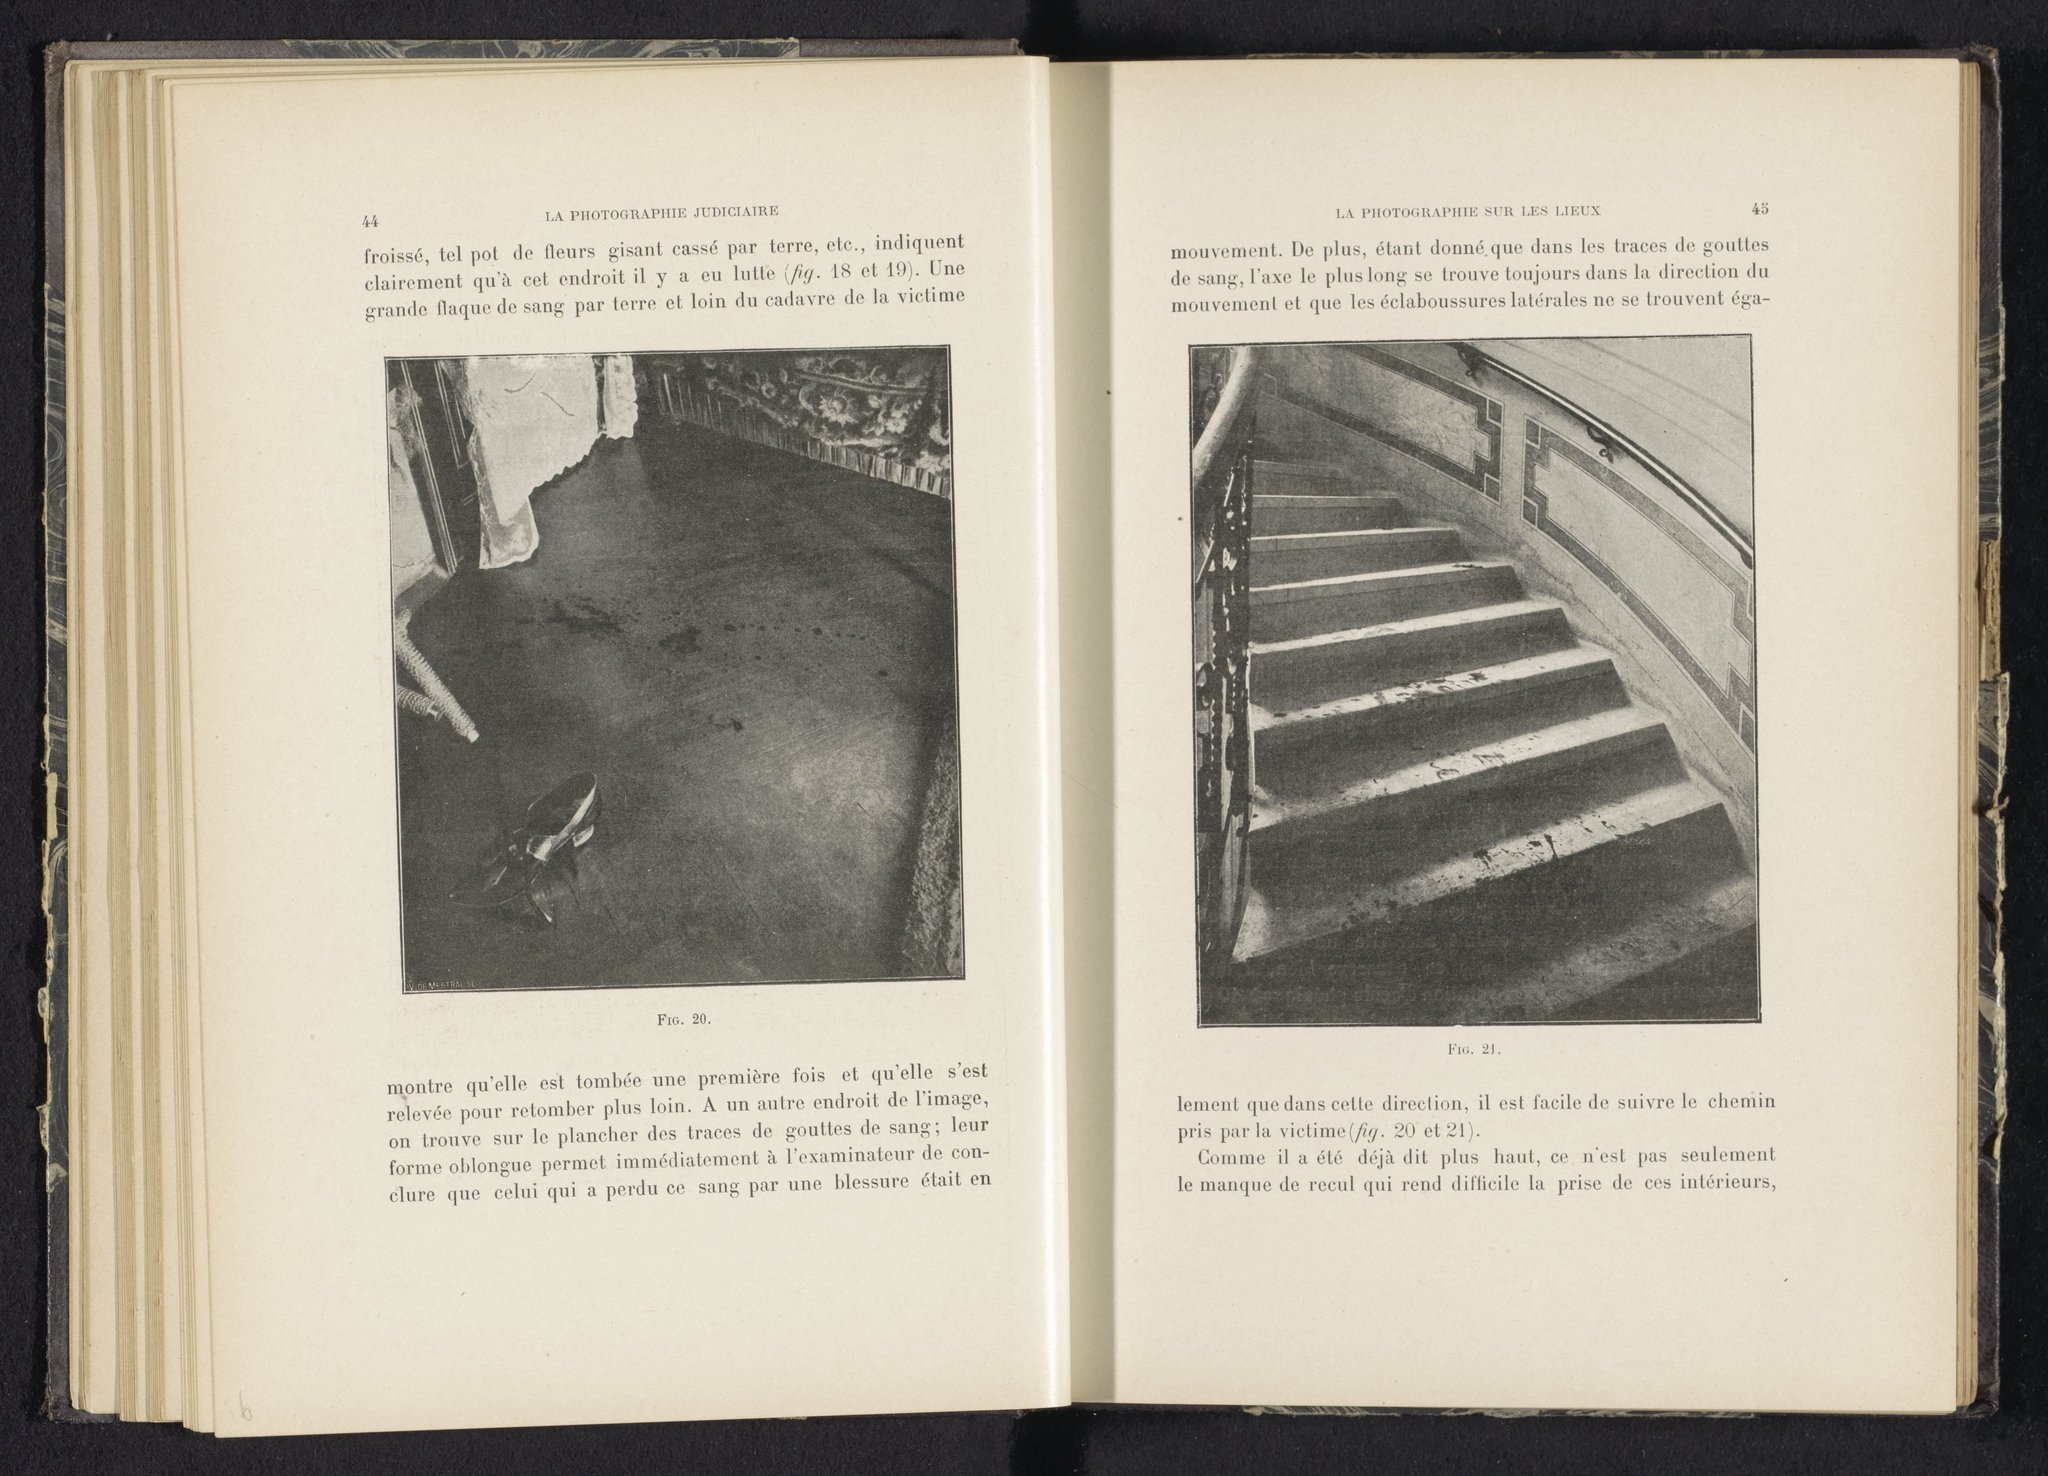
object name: page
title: Plaats delict met bloedspatten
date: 1893-1903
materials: paper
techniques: autotype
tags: blood, visiting the scene of the crime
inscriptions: number: ‘Fig. 20.’